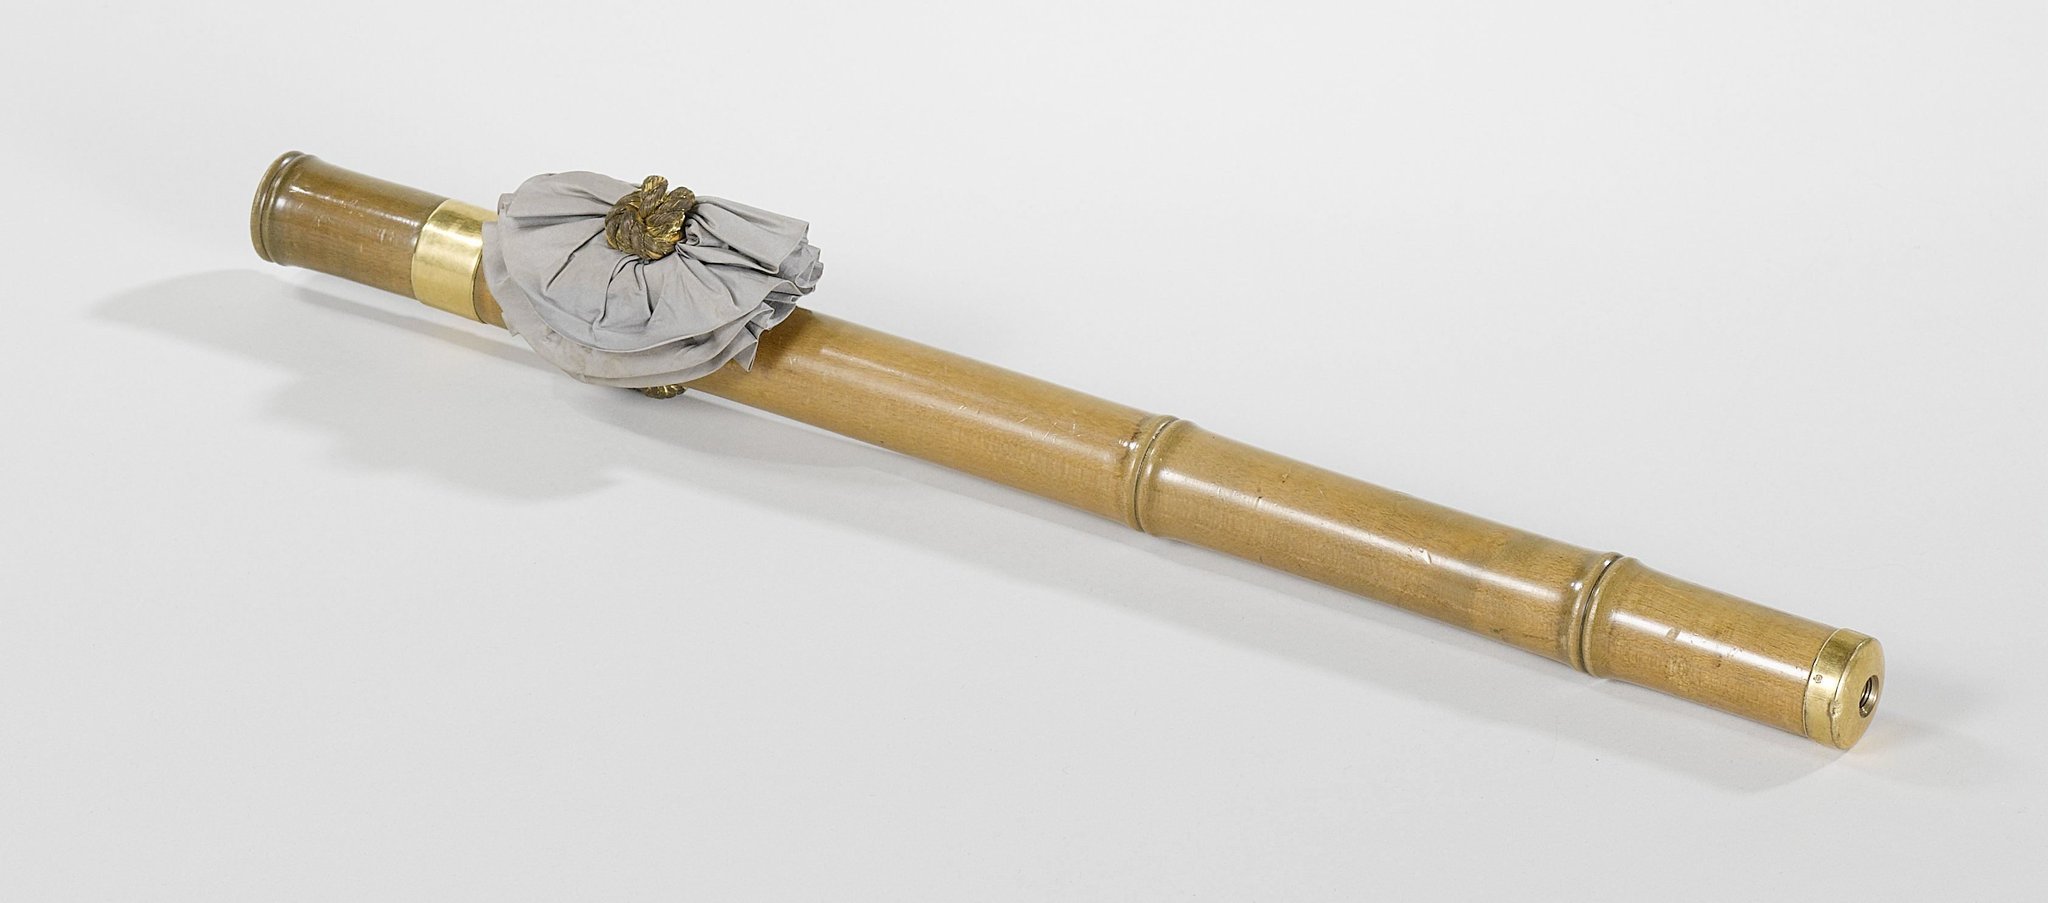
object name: umbrella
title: Paraplu met dek van grijze zijde in een koker van esdoornhout, met verguld koperen beslag en een zijden koord met dito rozet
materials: copper, metal, silk, wood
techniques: cutting, weave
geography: regent street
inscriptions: serial number: ‘Reg. 346205’, : ‘18 CAR GP’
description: Paraplu met dek van grijze zijde in een koker van hout gesneden als bamboe, met verguld koperen beslag en een zijden koord met dito rozet. Model: parasoldek van muisgrijze zijde. Houten punt. De metalen steel van het parasolletje wordt in de bovenkant van de houten koker geschroefd. De deksel wordt onderaan dichtgeschroefd. Versiering: de koker is in de vorm van bamboe gesneden. Aan een dikgoudkleurig koord een grijs zijden rozet met hart van geknoopt koord.